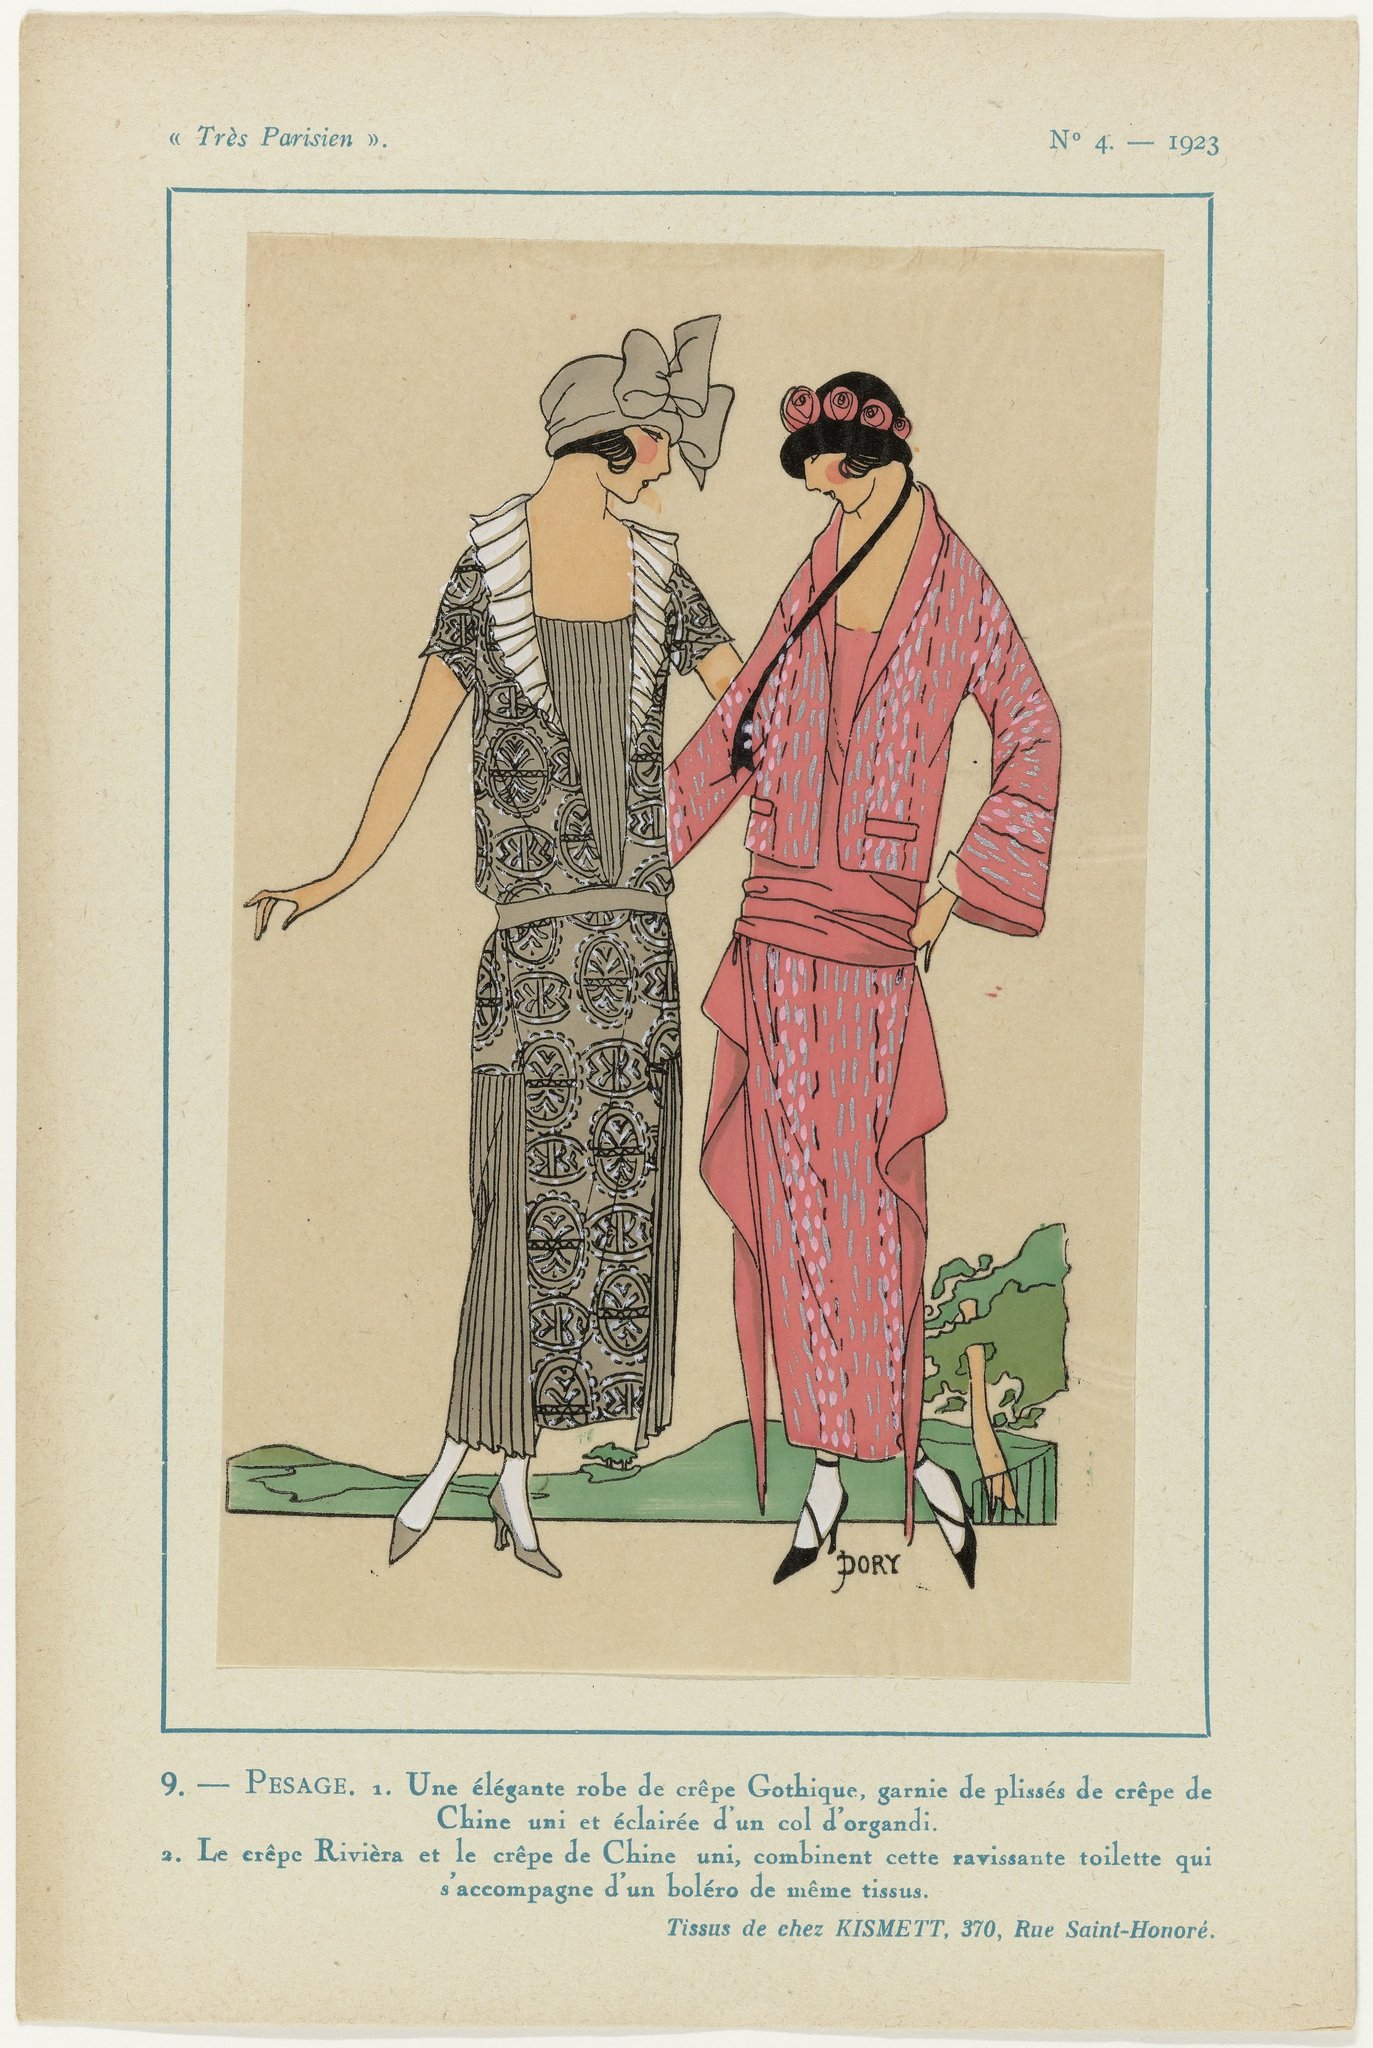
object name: fashion print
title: Très Parisien, 1923, No. 4: 9. - PESAGE. 1. Une élégante robe de crêpe Gothique...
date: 1923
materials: paper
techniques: hand coloring, letterpress printing, lithography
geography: paris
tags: arm in arm (friends), clothing for the upper part of the body (bolero) (+ women's clothes), neck-gear: collar (+ women's clothes), fashion plates, head-gear: hat (+ women's clothes), dress, gown (+ women's clothes)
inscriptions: caption: ‘9. - PESAGE. 1. Une élégante robe de crêpe Gothique, garnie de plissés de crêpe de Chine uni et éclairée d'un col d'organdi. 2. Le crêpe Rivièra et le crêpe de Chine uni, combinent cette ravissante toilette qui s'accompagne d'un boléro de même tissus. / Tissus de chez KISMETT, 370, Rue Saint-Honoré.’, title: ‘Très Parisien / No 4. - 1923’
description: 1. Jurk van 'crêpe Gothique' gegarneerd met plooien van effen 'crêpe de Chine' en een kraag van organdi. 2. 'Toilette' van 'crêpe Ruivièra' en effen 'crêpe de Chine'; bolero van dezelfde stoffen. Stoffen van Kismett. Prent uit het modetijdschrift Très Parisien (1920-1936).